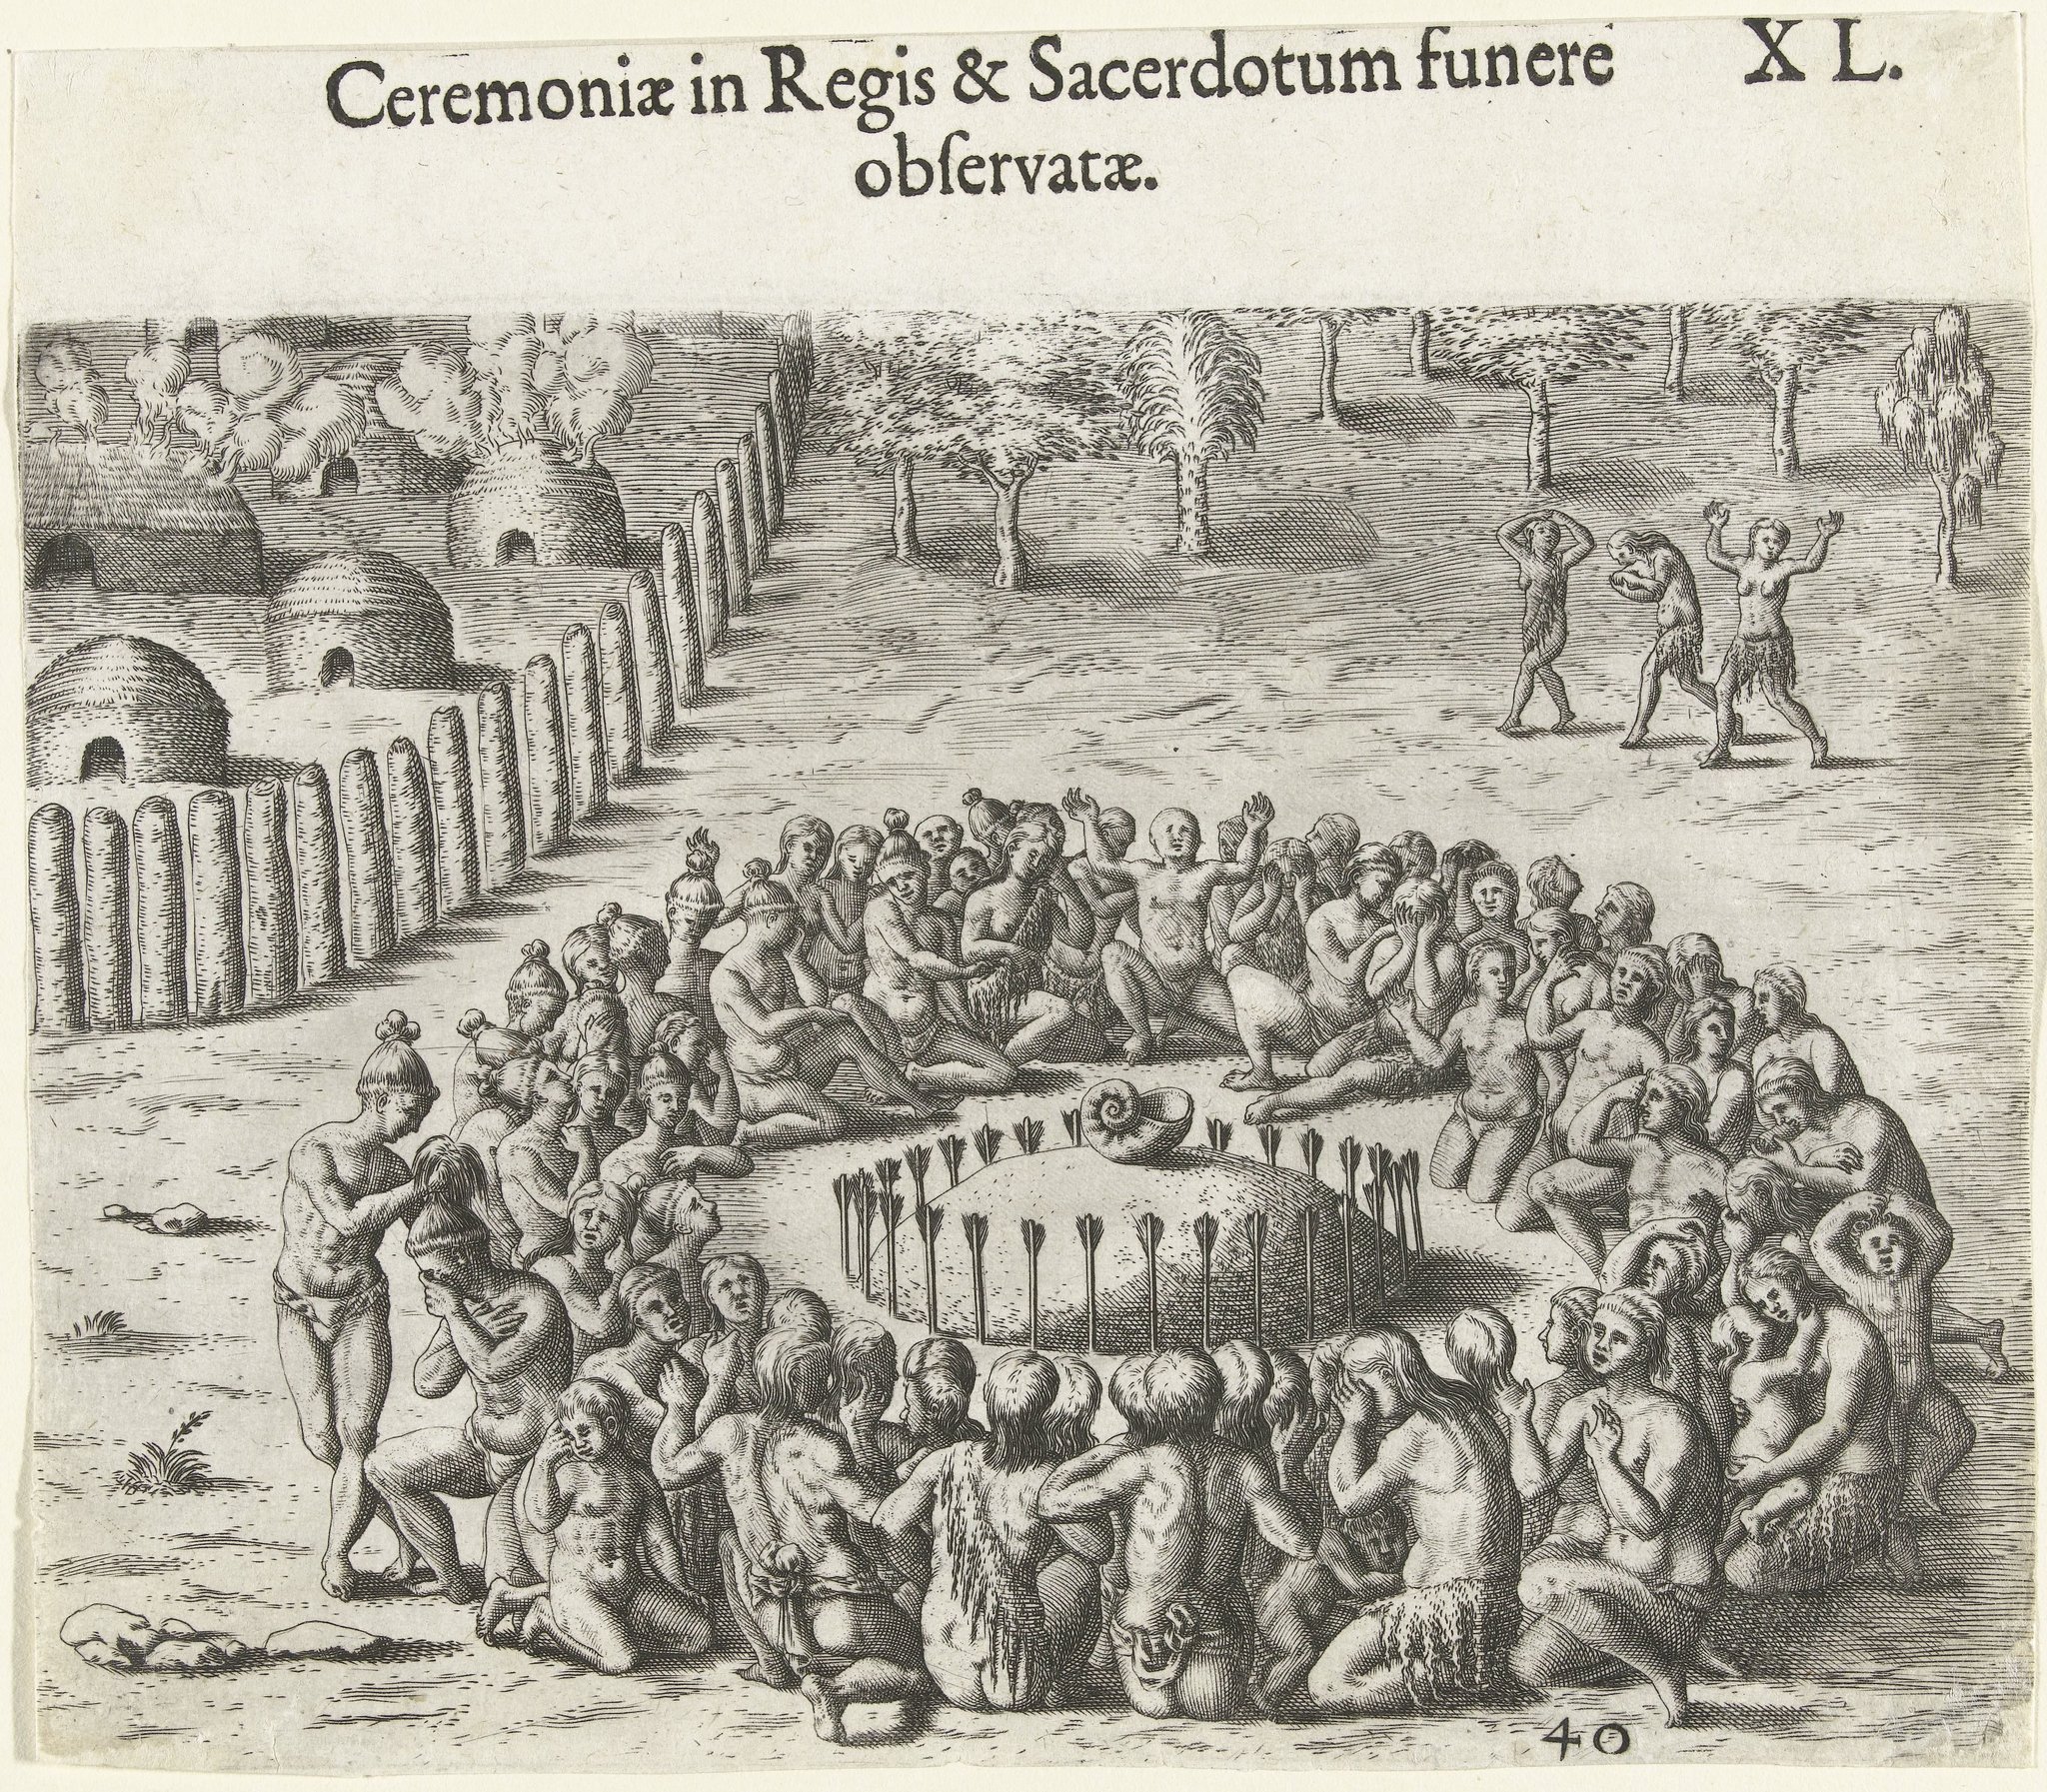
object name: print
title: Ceremoniae in Regis & Sacerdotum funere observatae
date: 1591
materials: paper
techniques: engraving, letterpress printing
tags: funerary ritual, ancestor cult ~ american indian religions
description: Het graf van de koning is met pijlen afgezet, op een heuvel ligt een schelp. Om de heuvel zitten de mannen, vrouwen en kinderen uit de stam te rouwen. De grafheuvel ligt buiten de omheining van het dorp. In het dorp zijn een aantal hutten in brand gestoken.